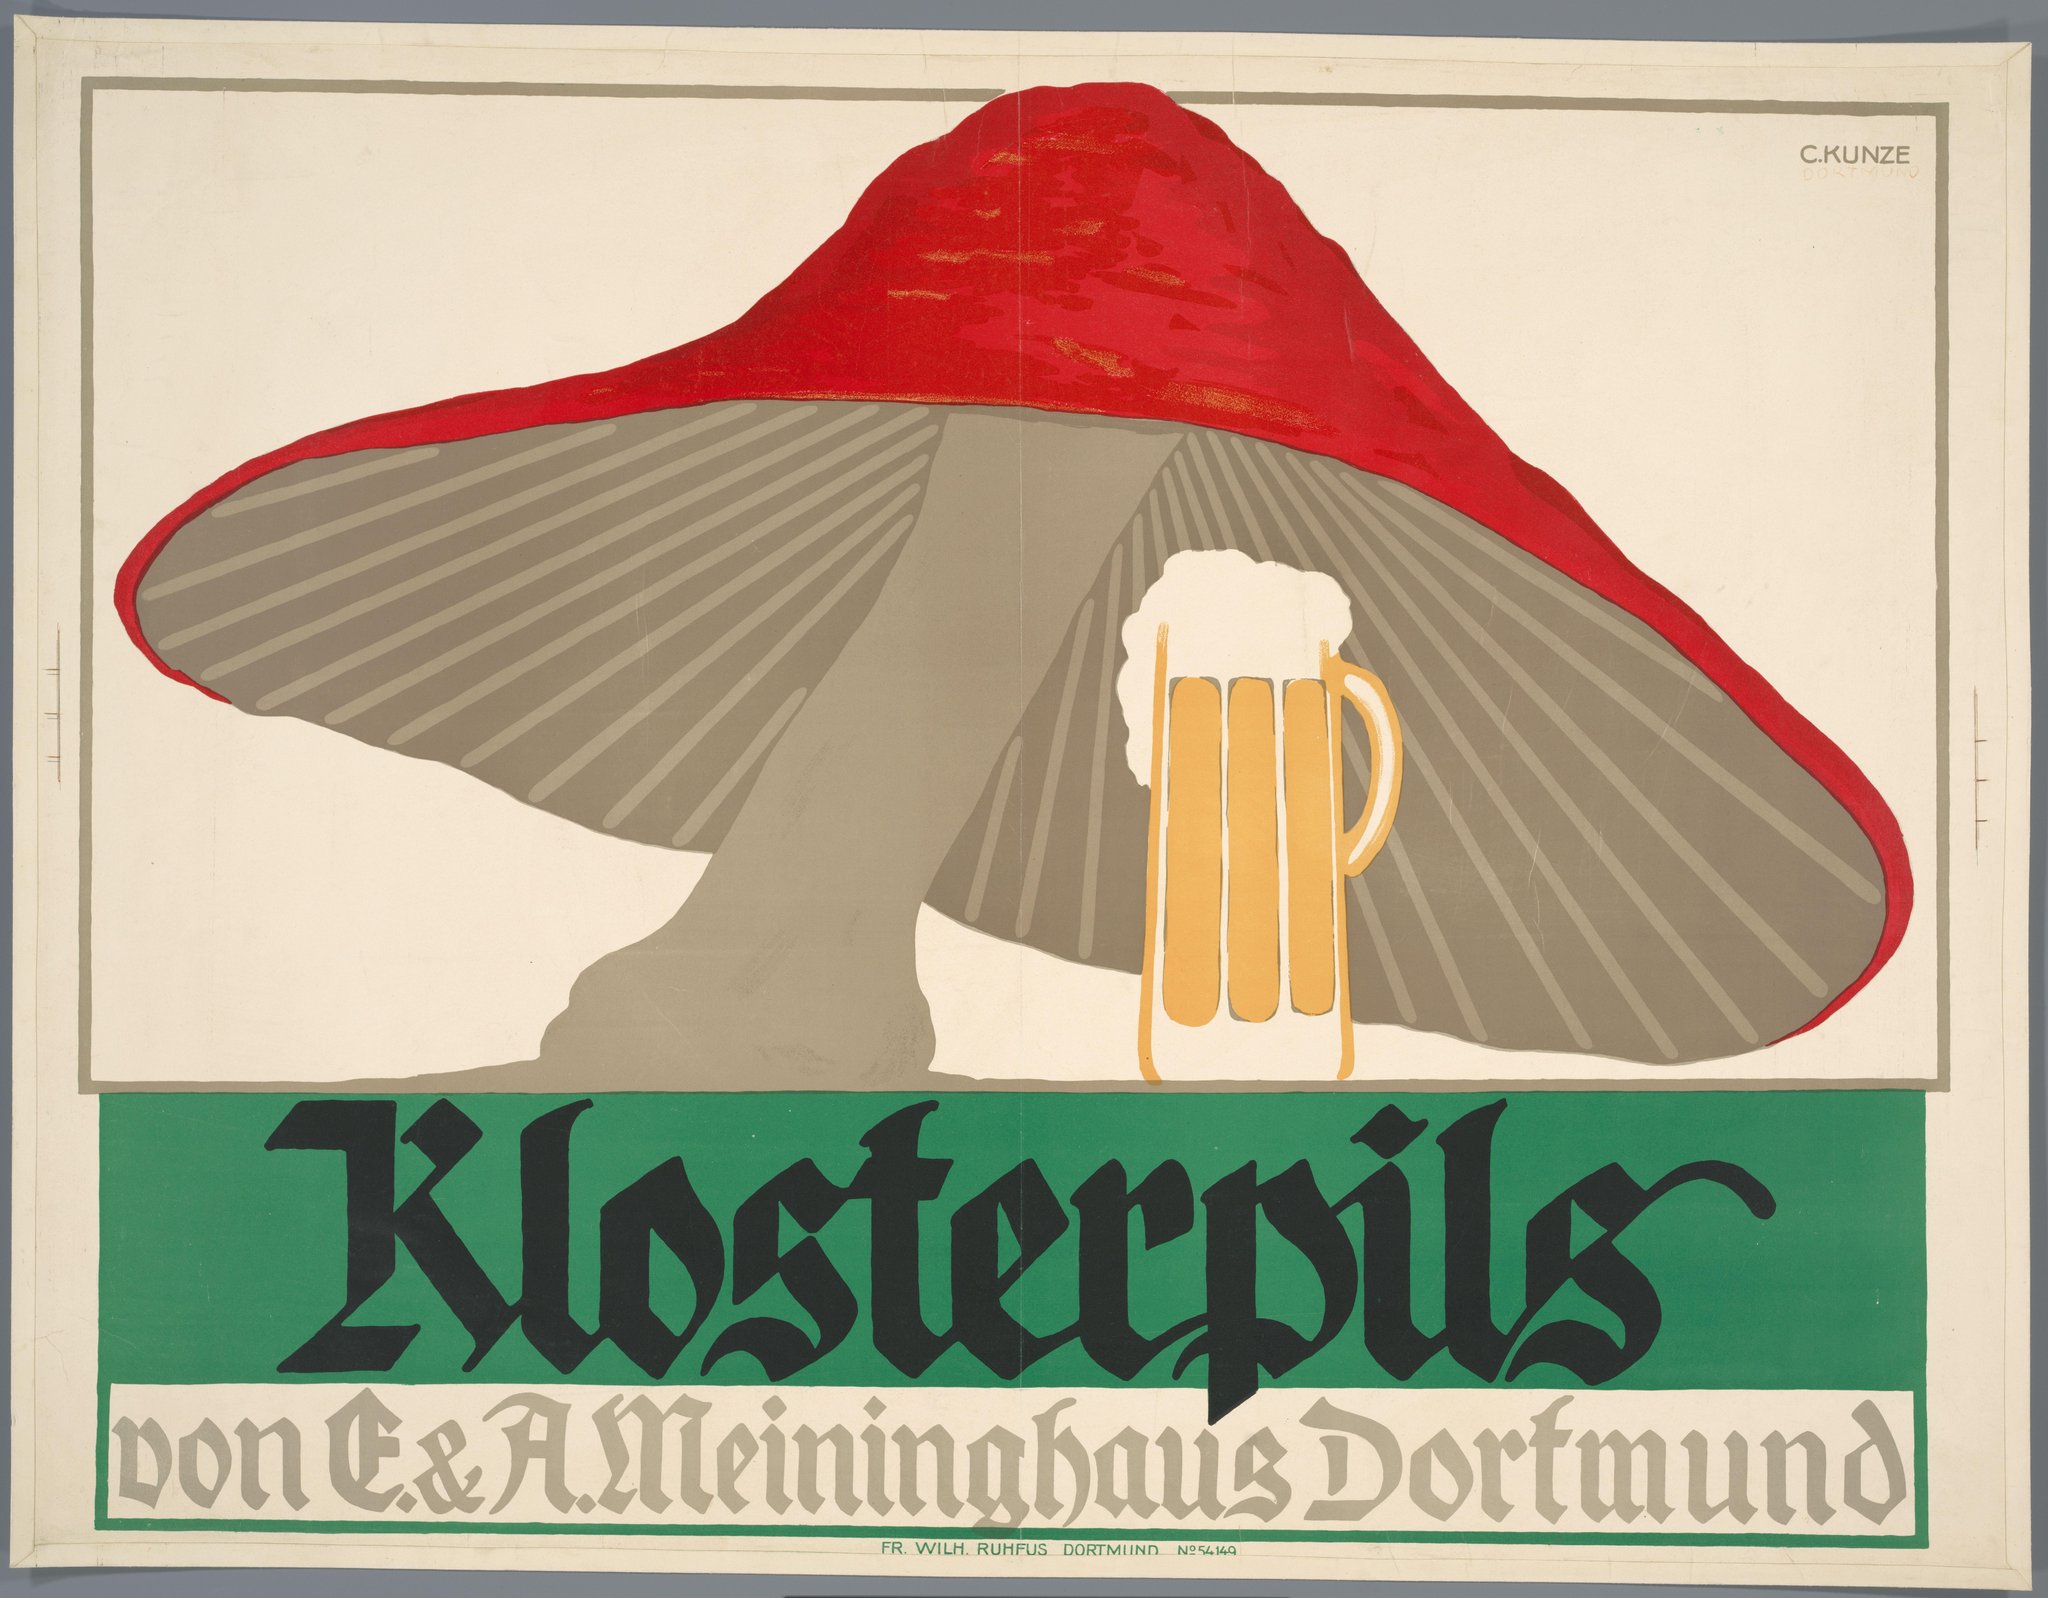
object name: poster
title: Poster Klosterpilz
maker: carl kunze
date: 1912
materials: paper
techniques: lithograph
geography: dortmund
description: The designer Karl Kunze chose the graphic image of a frothing glass of beer under a mushroom to market the Klosterpils brand of beer. Thanks to effective advertising campaigns and factory production, this lager became a popular alcoholic beverage.